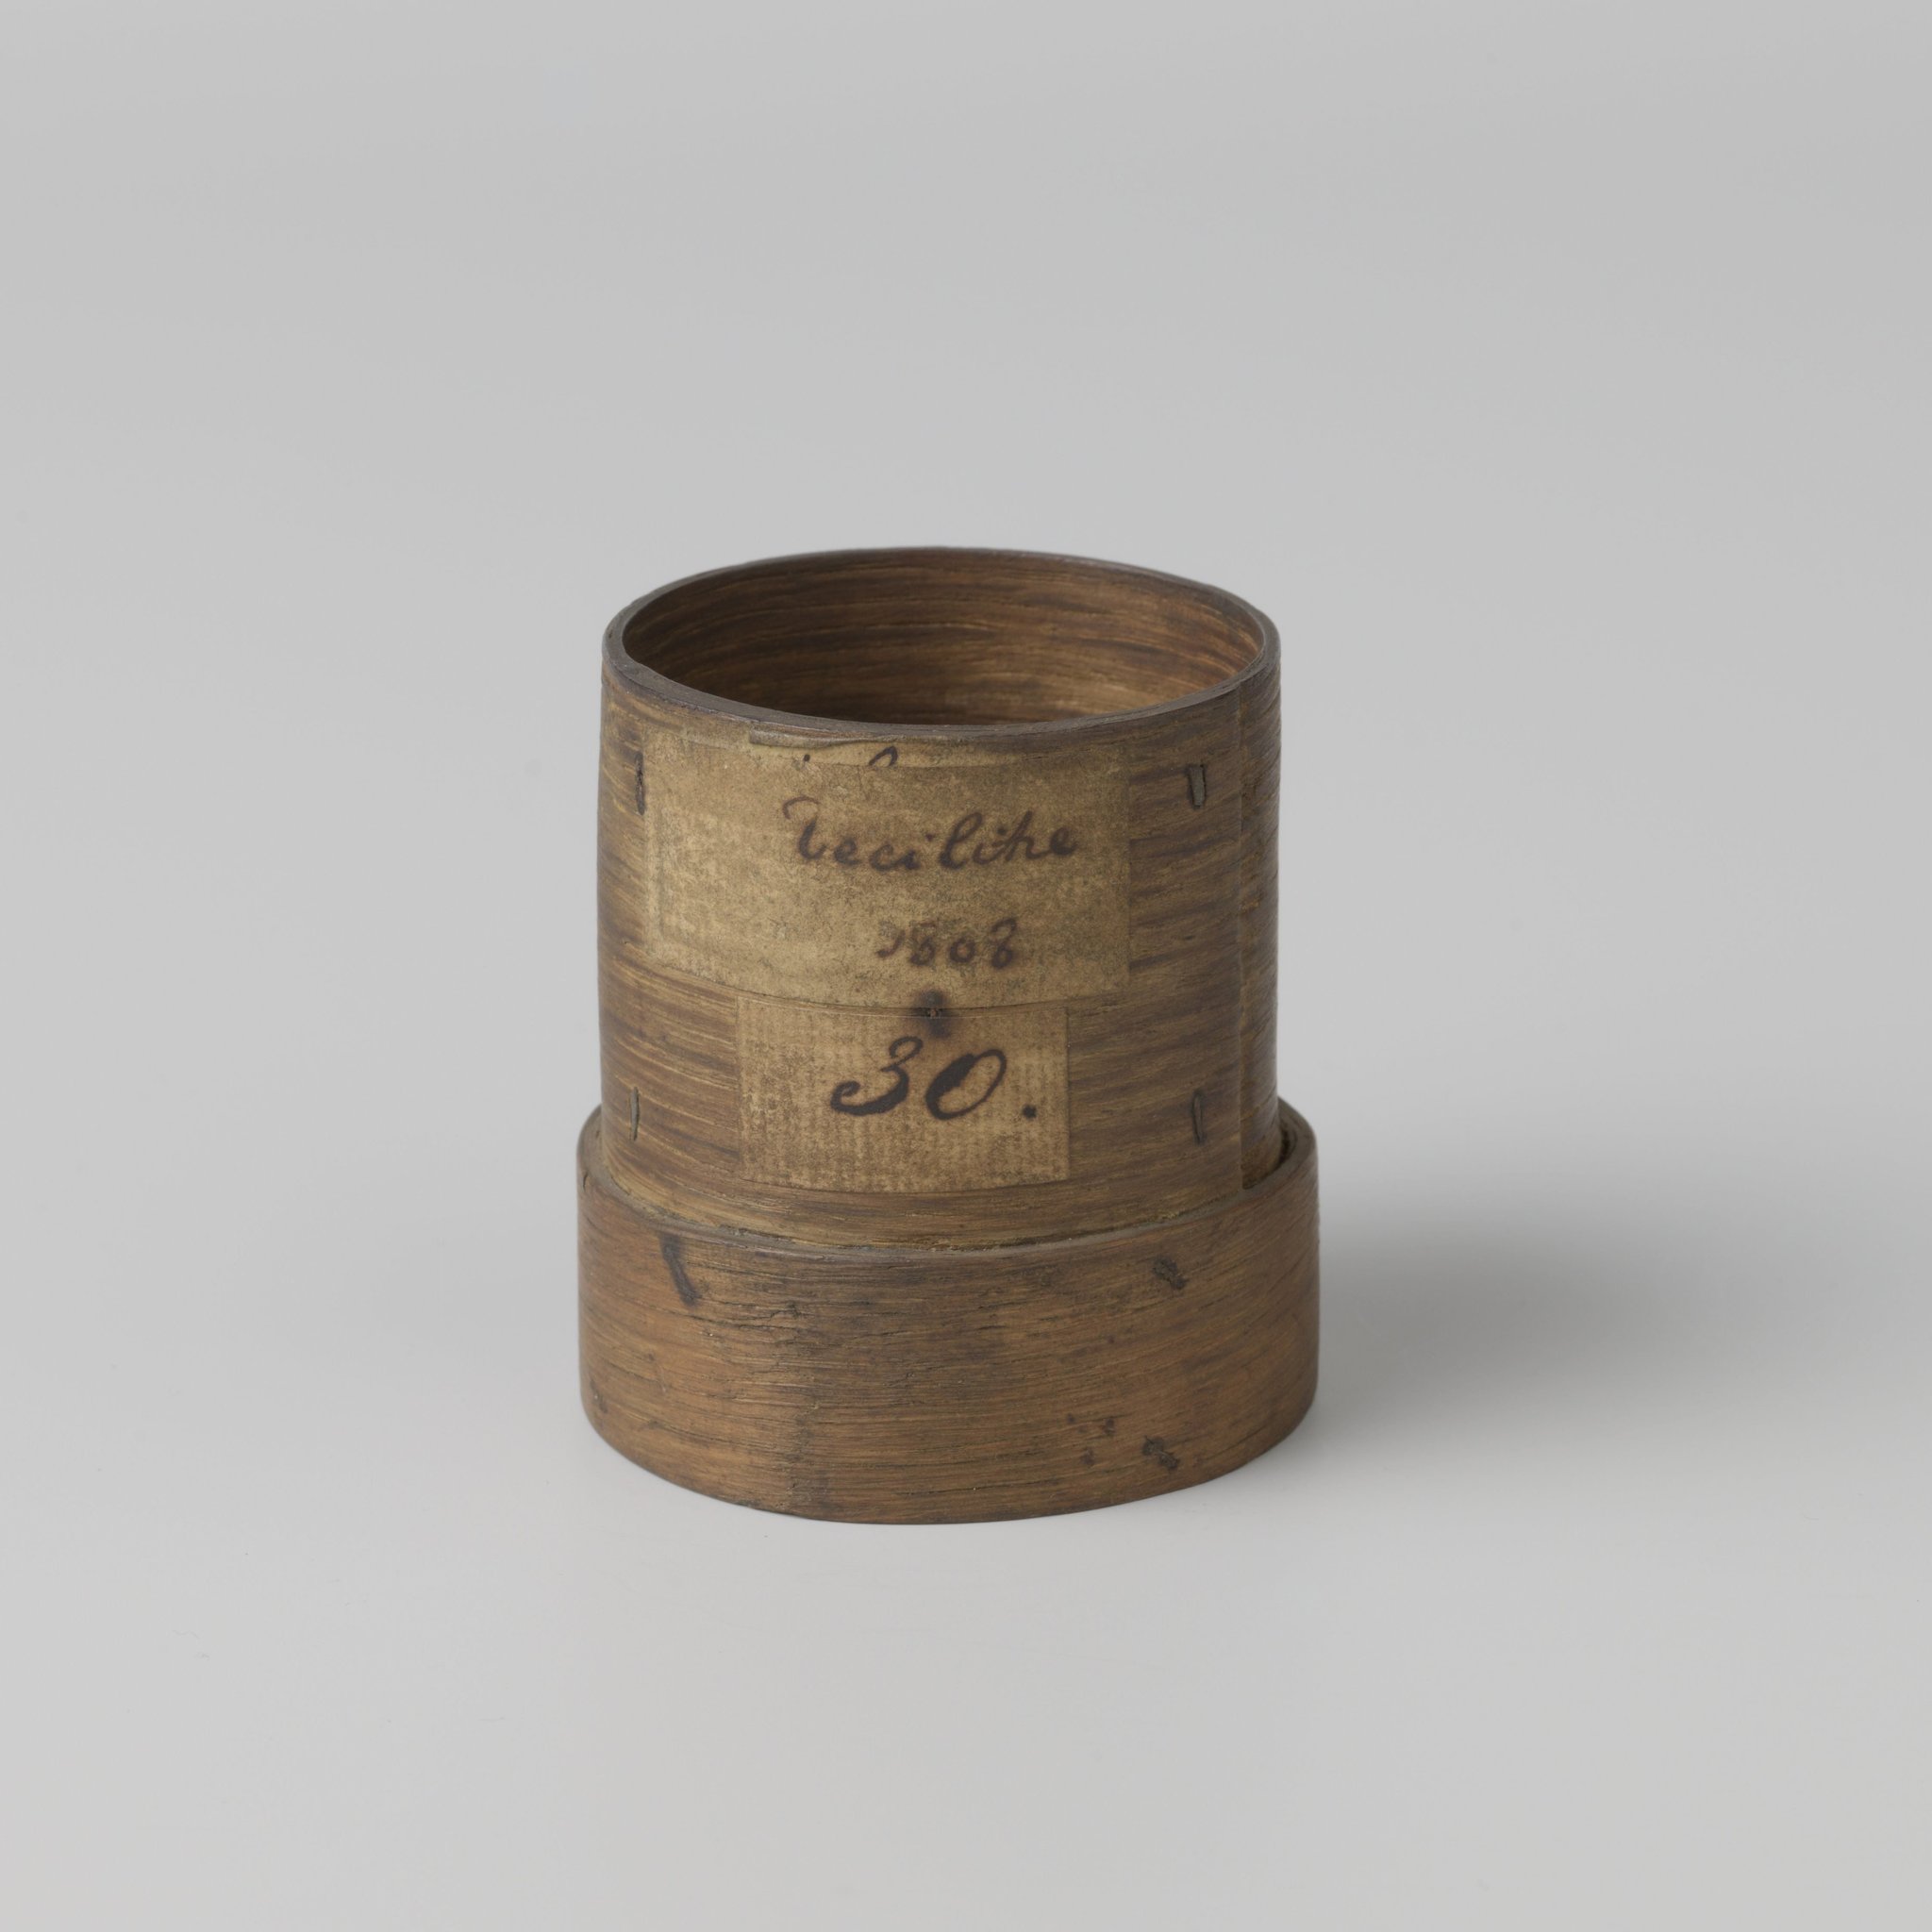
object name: inhoudsmaat droge waren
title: Inhoudsmaat van 1 deciliter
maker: Anonymous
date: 1825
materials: wood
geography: netherlands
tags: netherlands